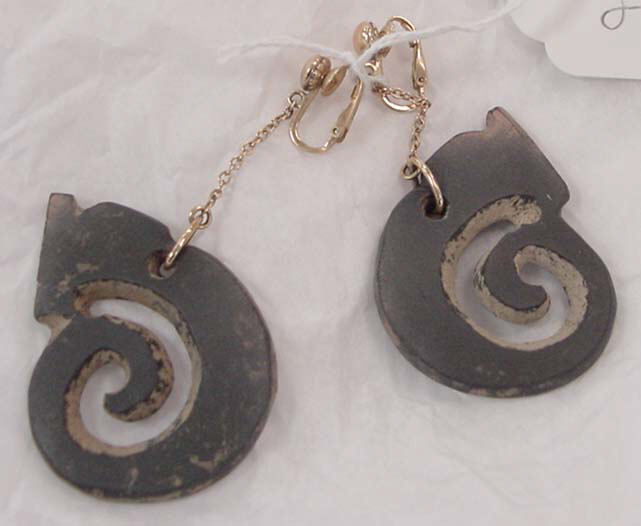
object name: earring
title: Earrings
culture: chinese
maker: muriel kallis newman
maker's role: designer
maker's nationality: american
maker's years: 1914-2008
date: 1801-1900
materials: metal, stone